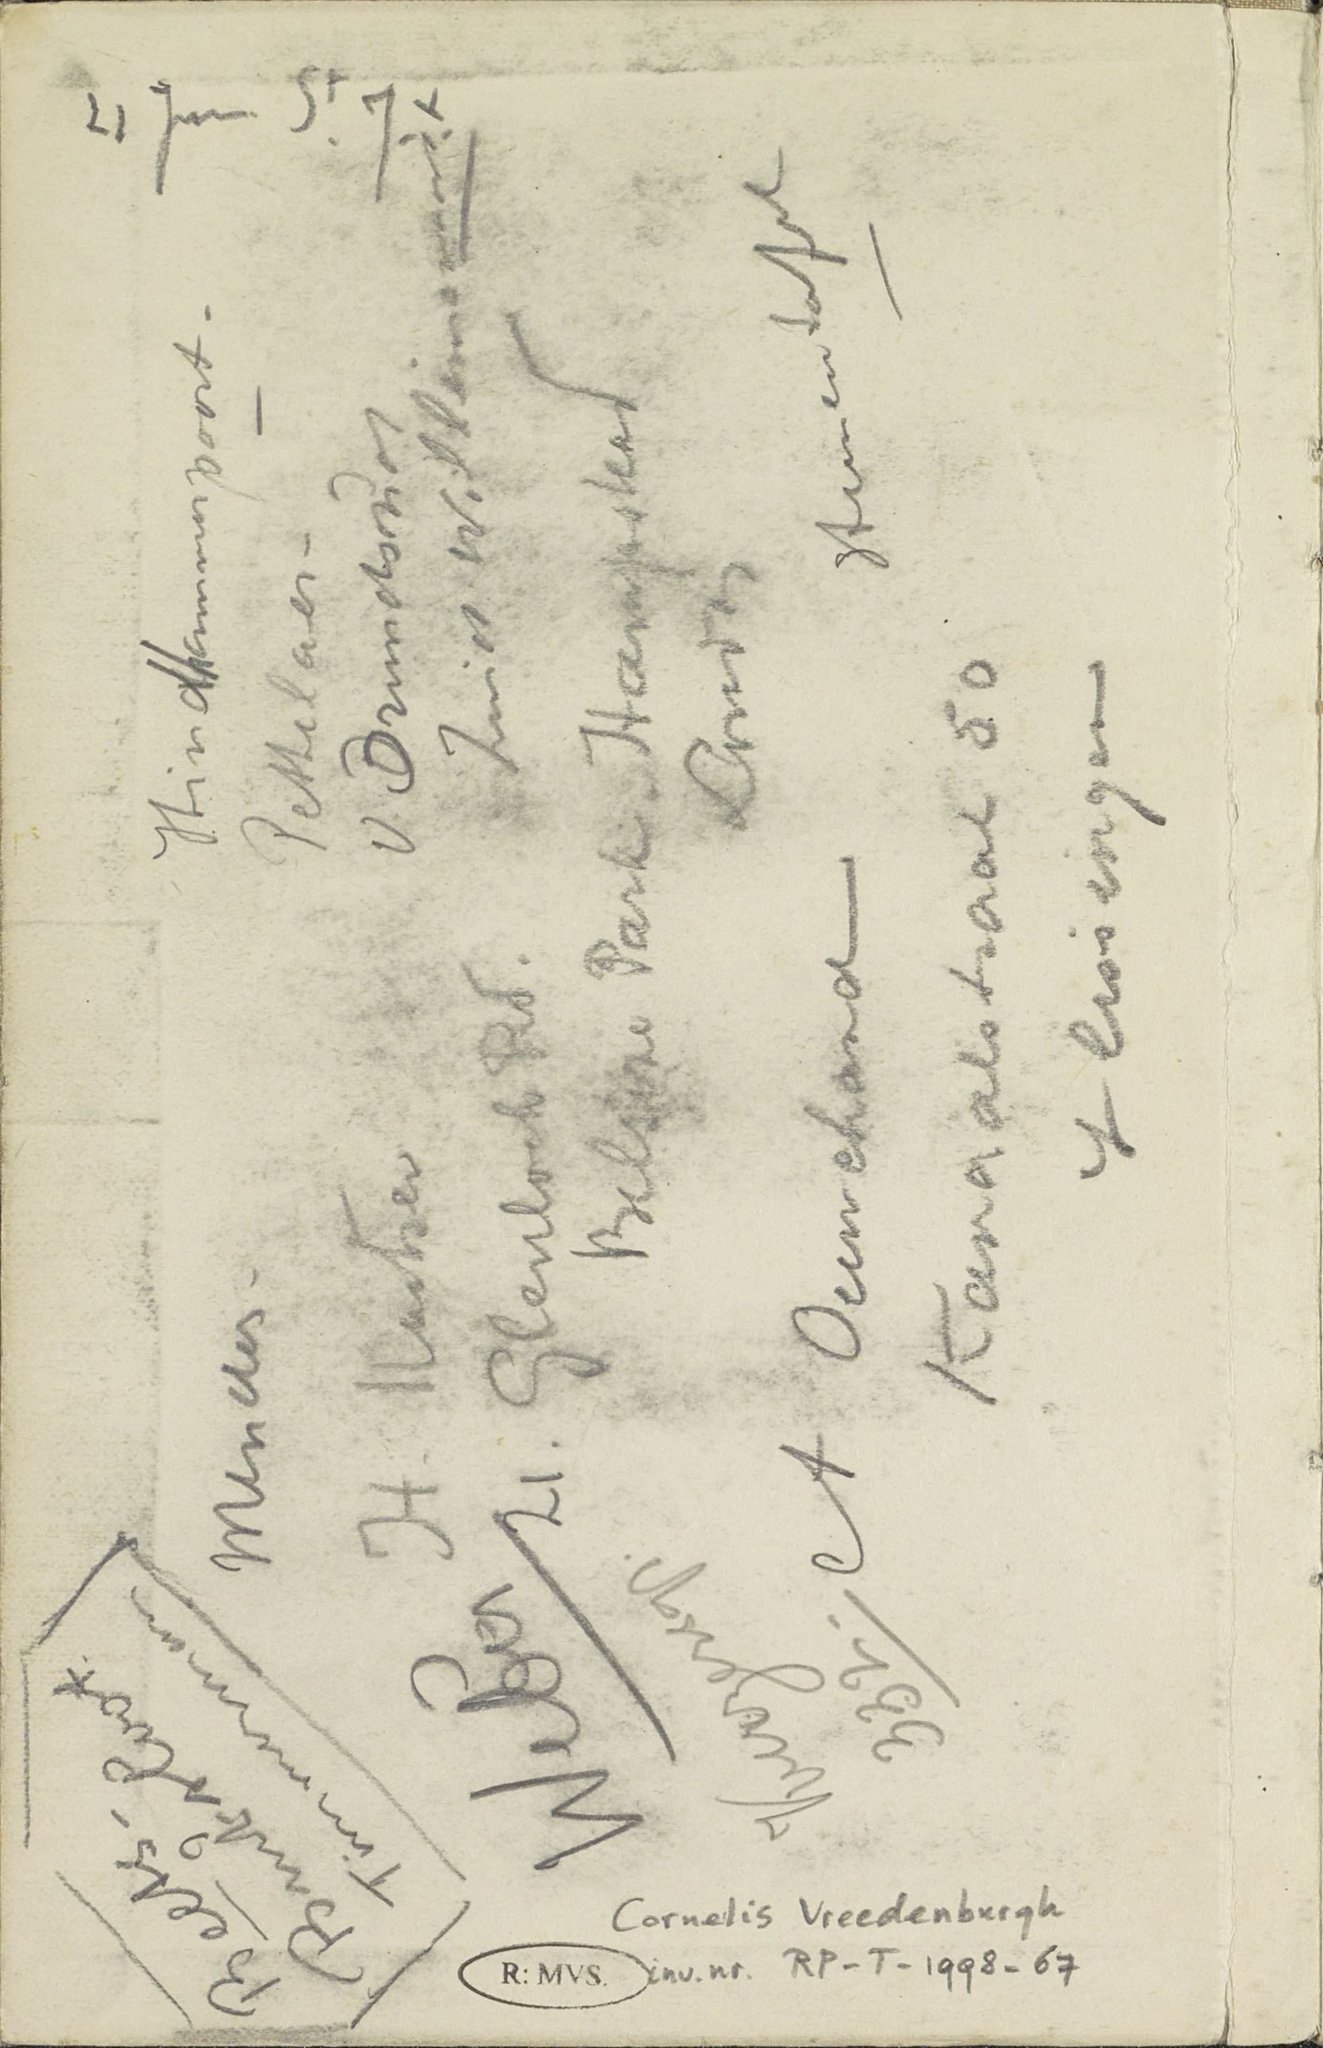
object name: endleaf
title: Notities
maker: cornelis vreedenburgh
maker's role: draughtsman, print maker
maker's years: 1880-1946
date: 1890-1946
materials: paper, pencil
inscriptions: collector's mark: Lugt 2228a, date and inscription: ‘21 Jun St7[...]/ Beets-/ Buntsloot/ Timmerman/ Mendes/H./ Huitsen/ H. Glenbeek [...]/ Belsize Park Hampstead/ London/ Hindkammerpoort/ Pettelaan. v. Brunds[...]/ A. Ouwehand/ Kanaalstraat 50/ Vlissingen [...]’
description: Voorste schutblad uit een schetsboek met 50 bladen.